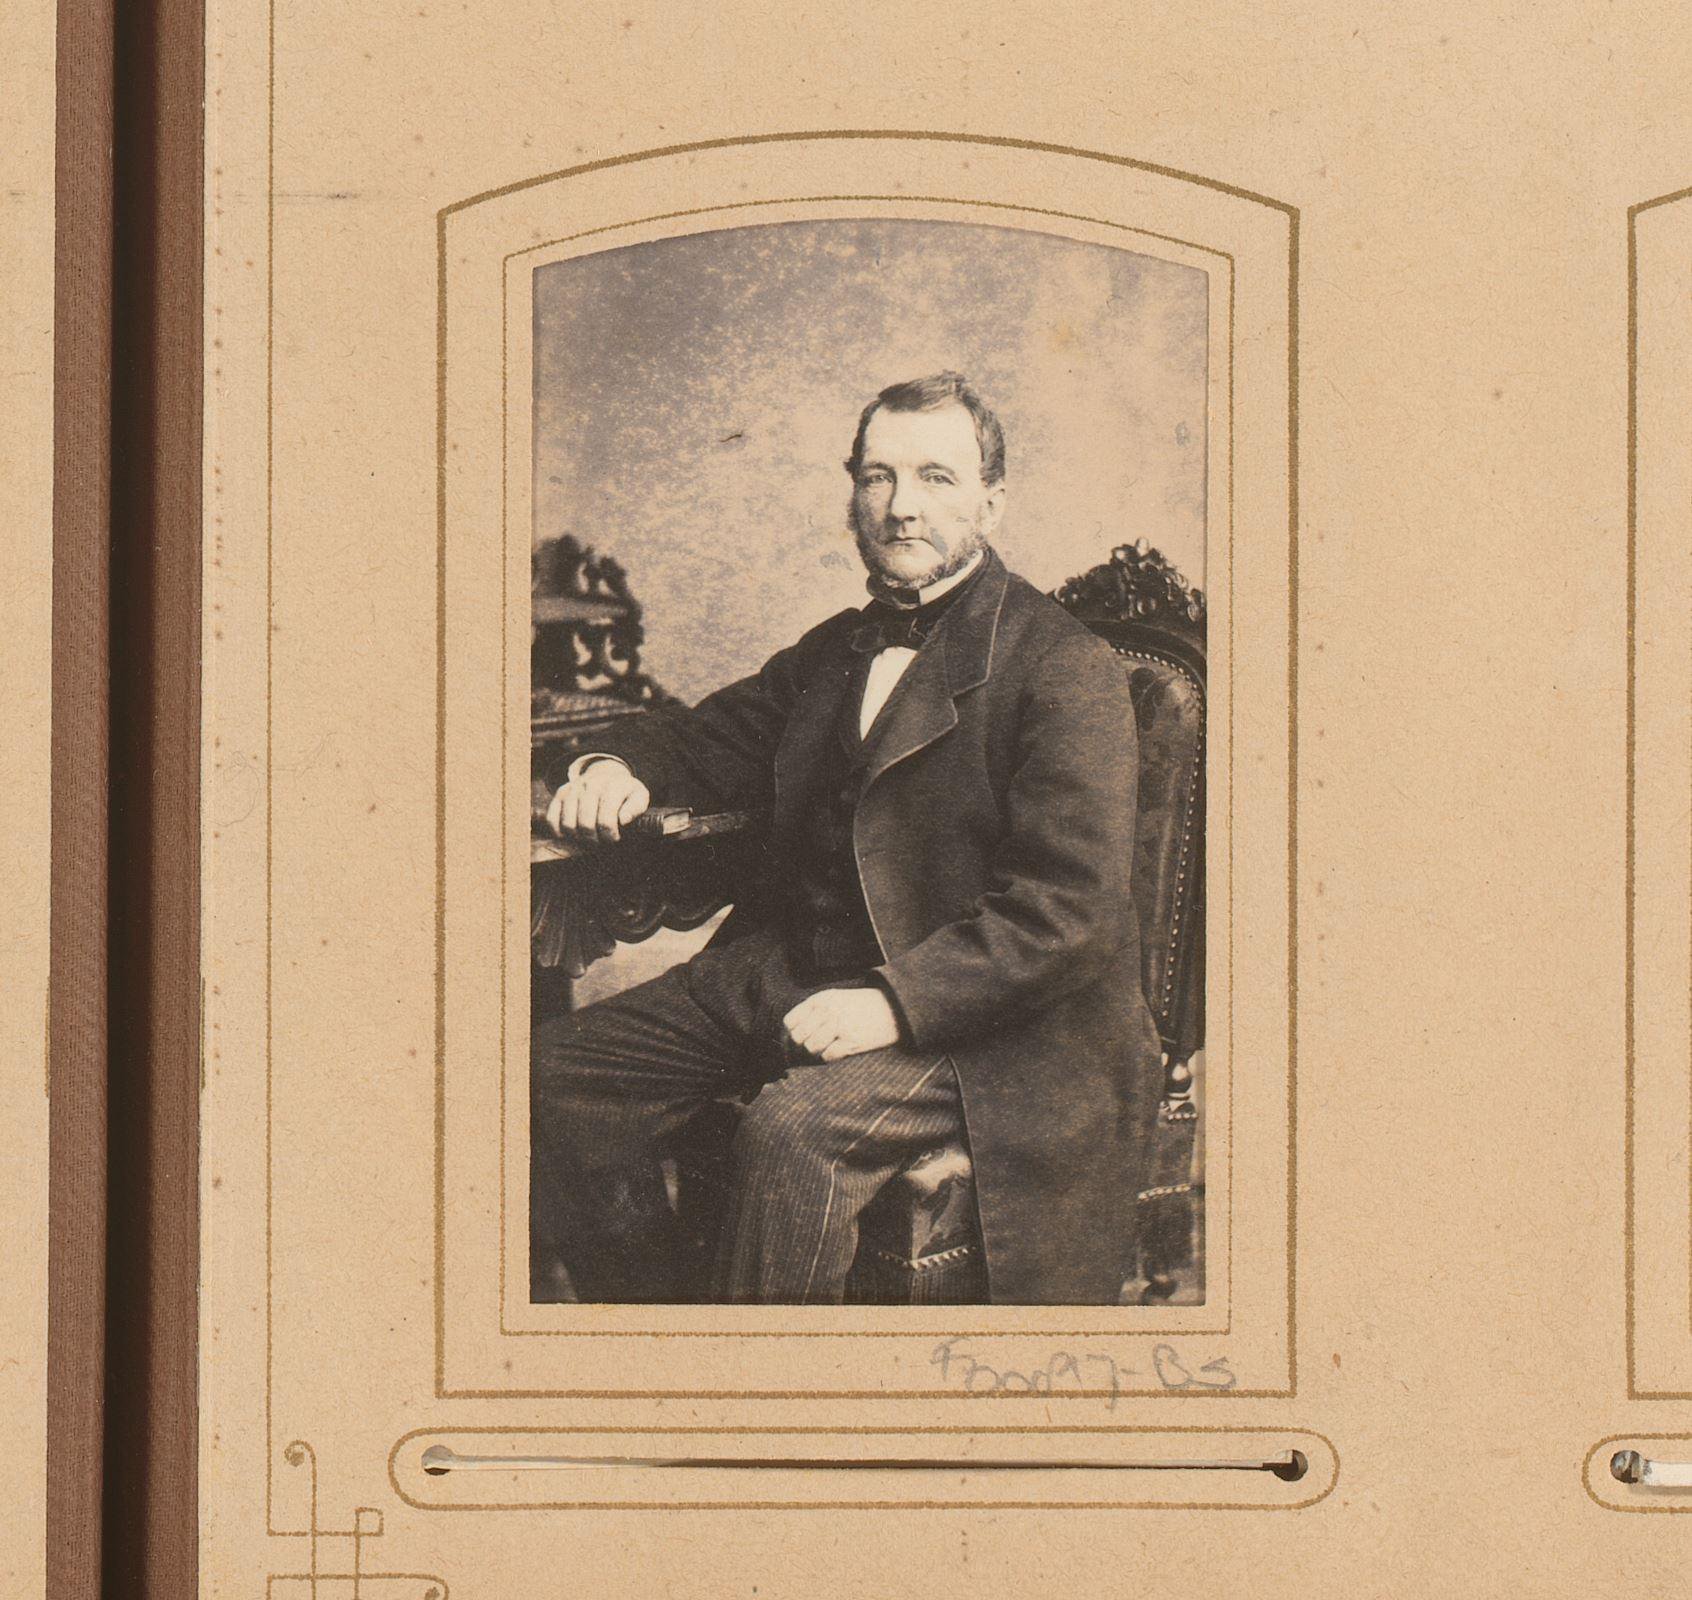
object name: carte de visite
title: Portret van een zittende man met boek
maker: a. böeseken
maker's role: fotograaf, lithograaf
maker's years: 1834-1919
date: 1868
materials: cardboard, photographic support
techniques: albumen print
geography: rotterdam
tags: historical persons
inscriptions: inscription: ‘Photographisch Atelier/ A. Böeseken/ Hoogstraat over de Vlasmarkt/ Rotterdam’, date: ‘10 Aug. 1868’